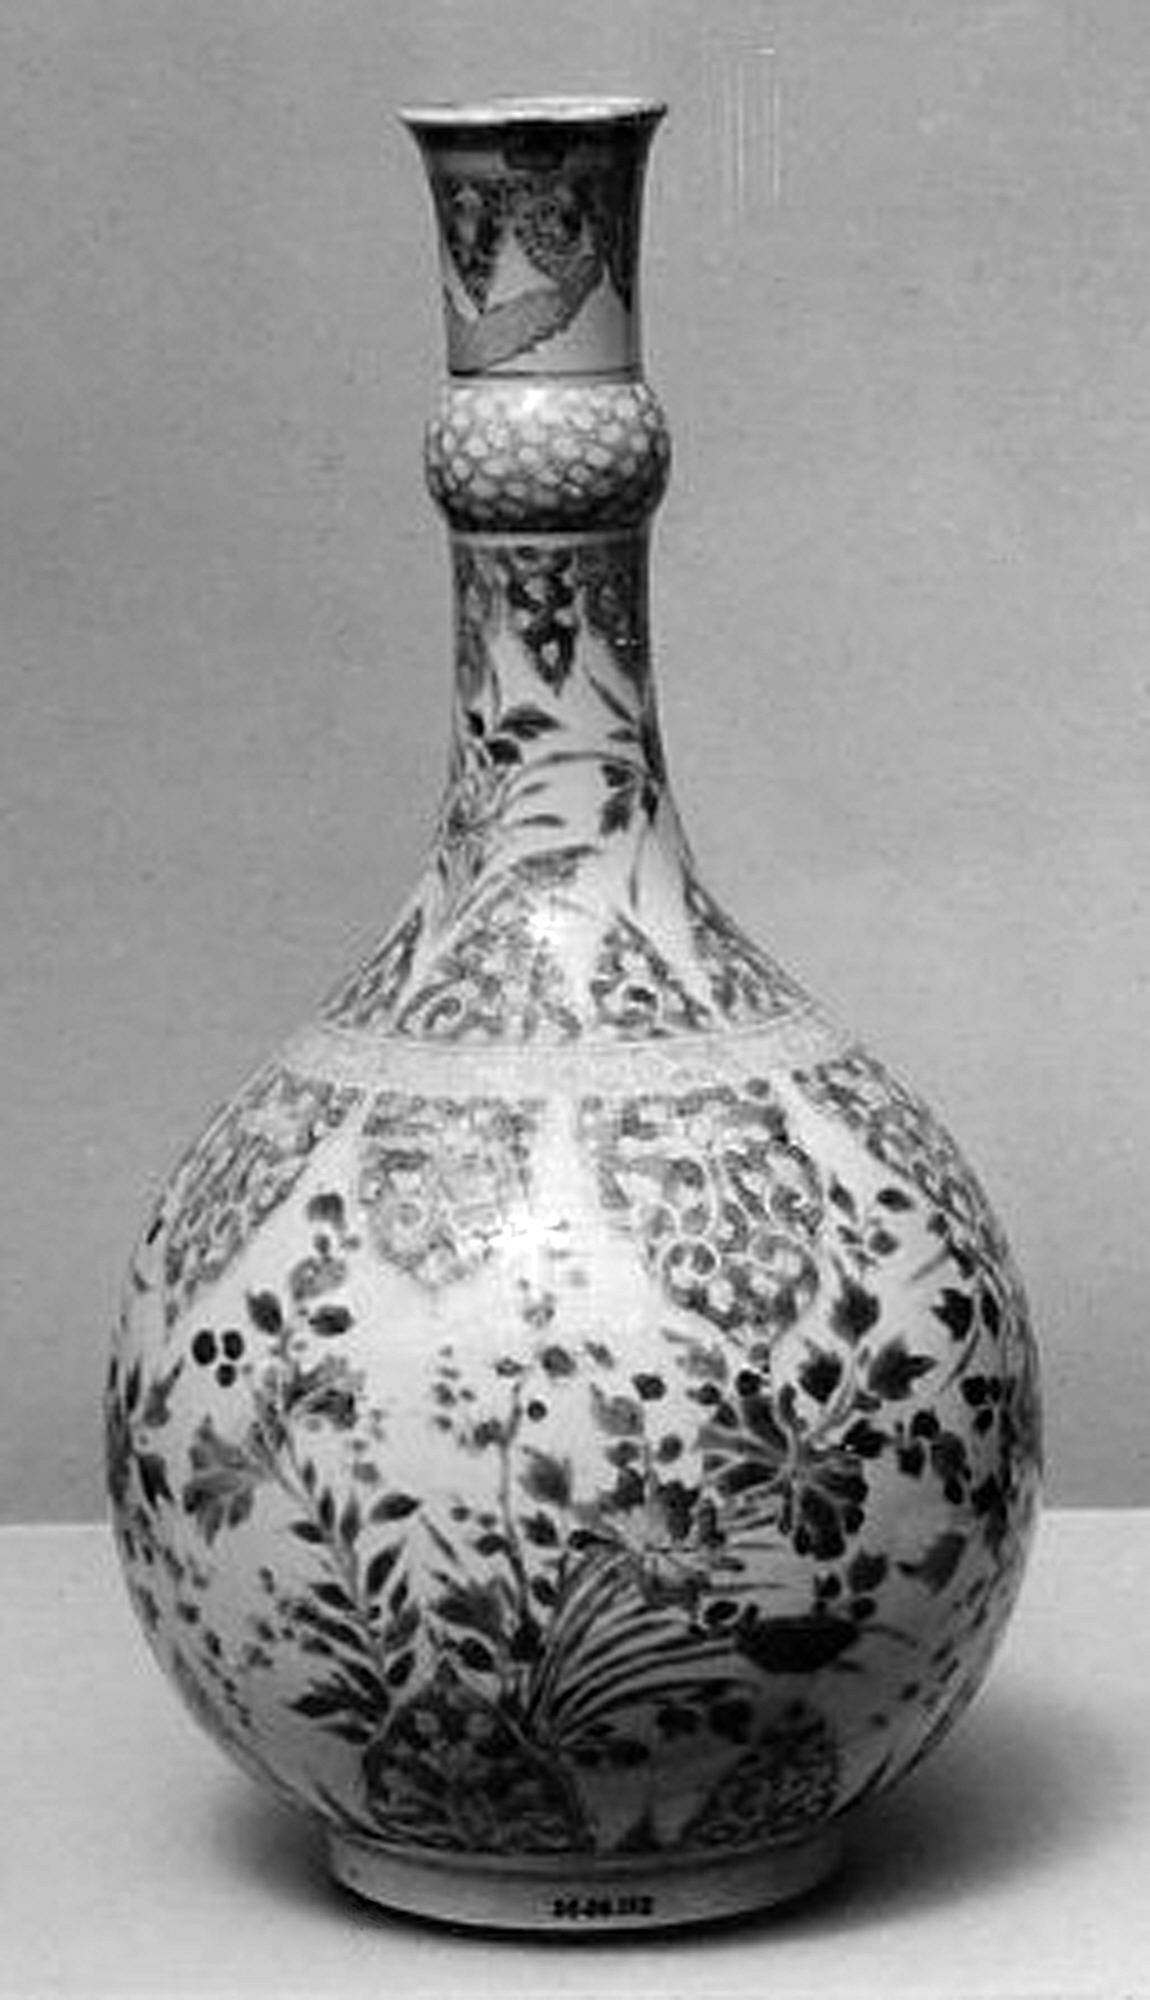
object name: bottle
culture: chinese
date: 1662-1722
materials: porcelain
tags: flowers,leaves